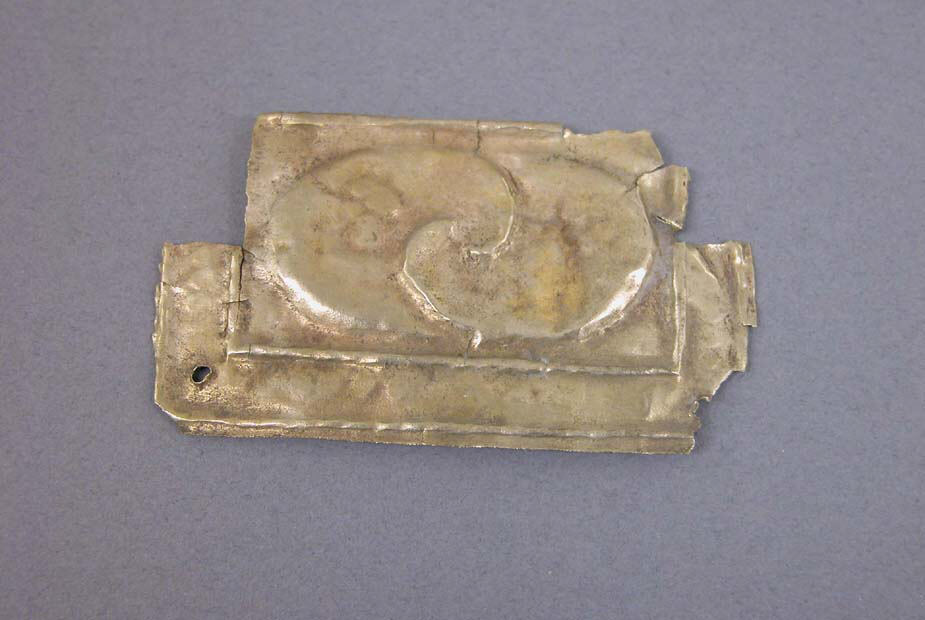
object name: fragment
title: Fragment of Appliqué with Cloud Motif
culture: indonesian, javanese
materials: gold